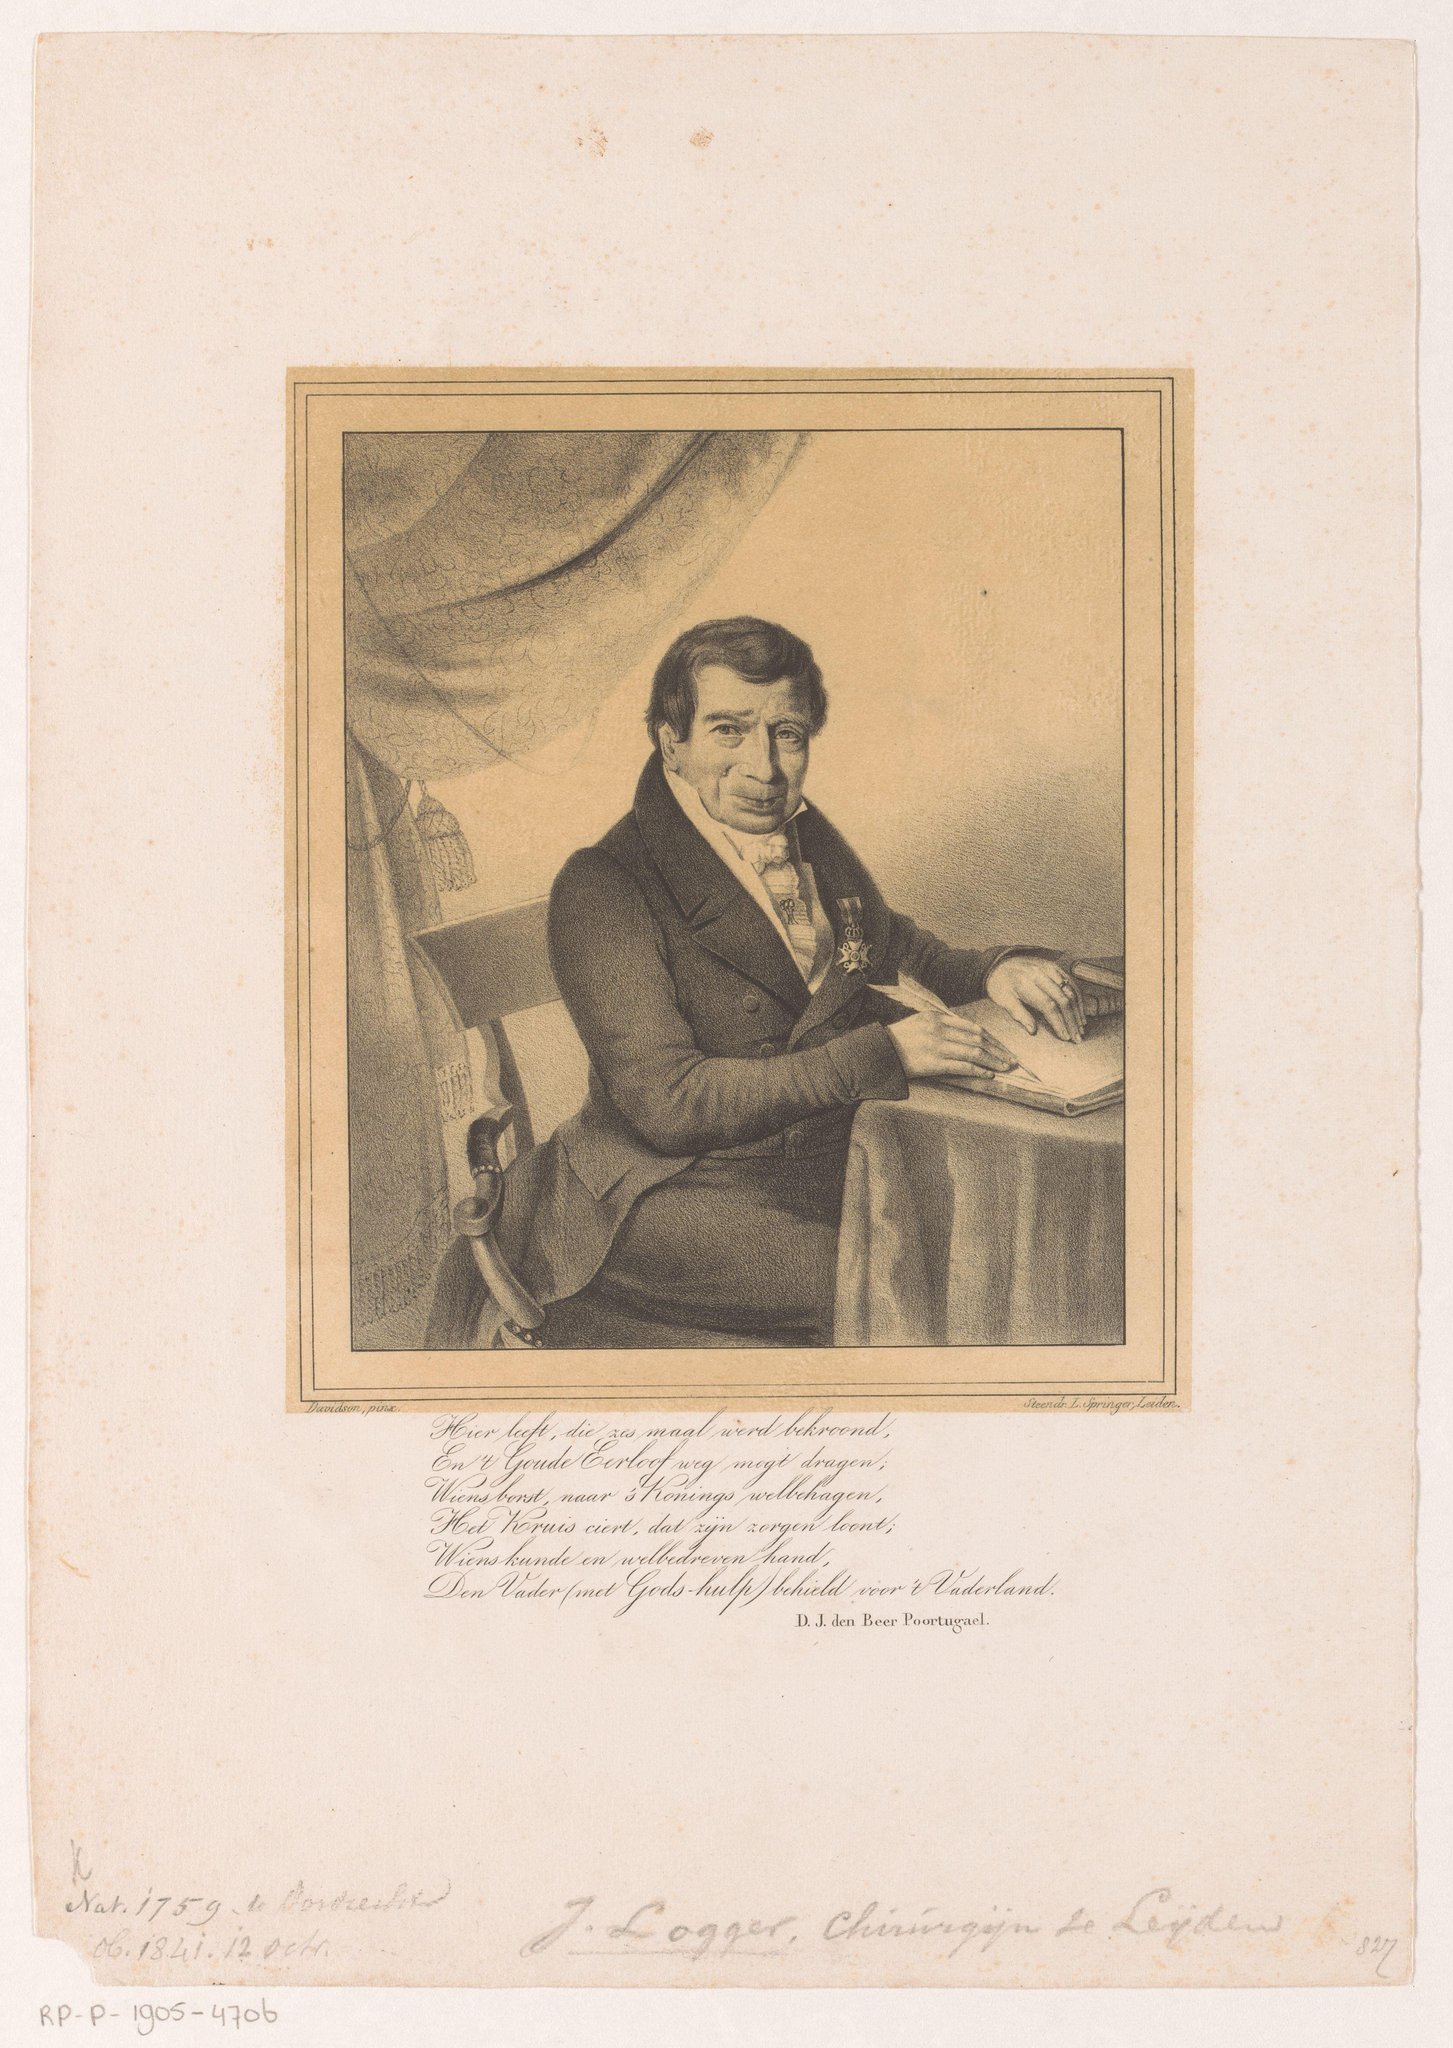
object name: print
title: Portret van Jacobus Logger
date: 1810-1871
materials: paper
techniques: tone lithography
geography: leiden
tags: dordrecht, leiden, historical persons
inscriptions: collector's mark: Lugt 2228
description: Onder het portret een zesregelig vers van Diederic Jacob den Beer Poortugael.